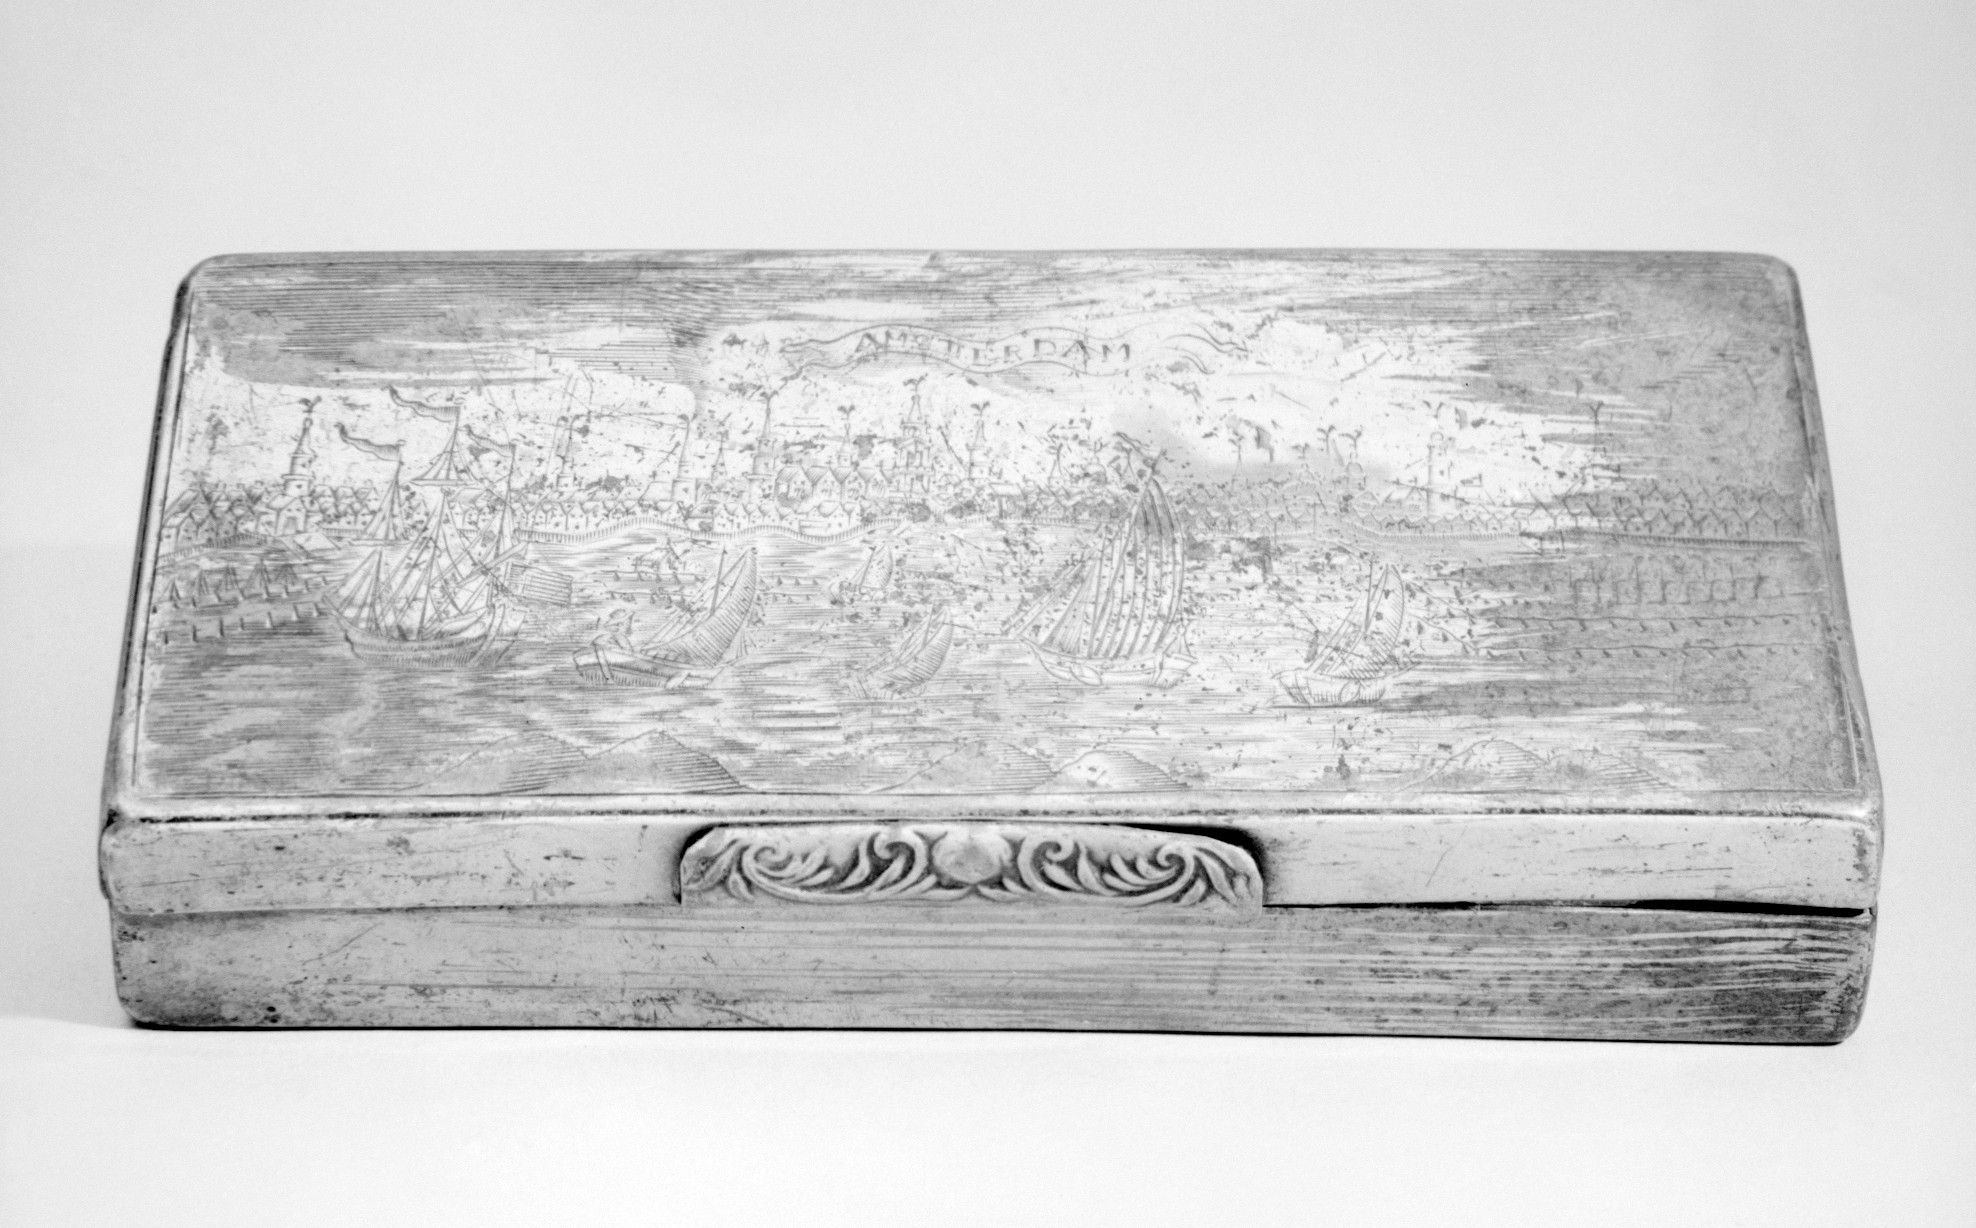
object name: tobacco box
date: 1701-1800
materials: brass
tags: ships